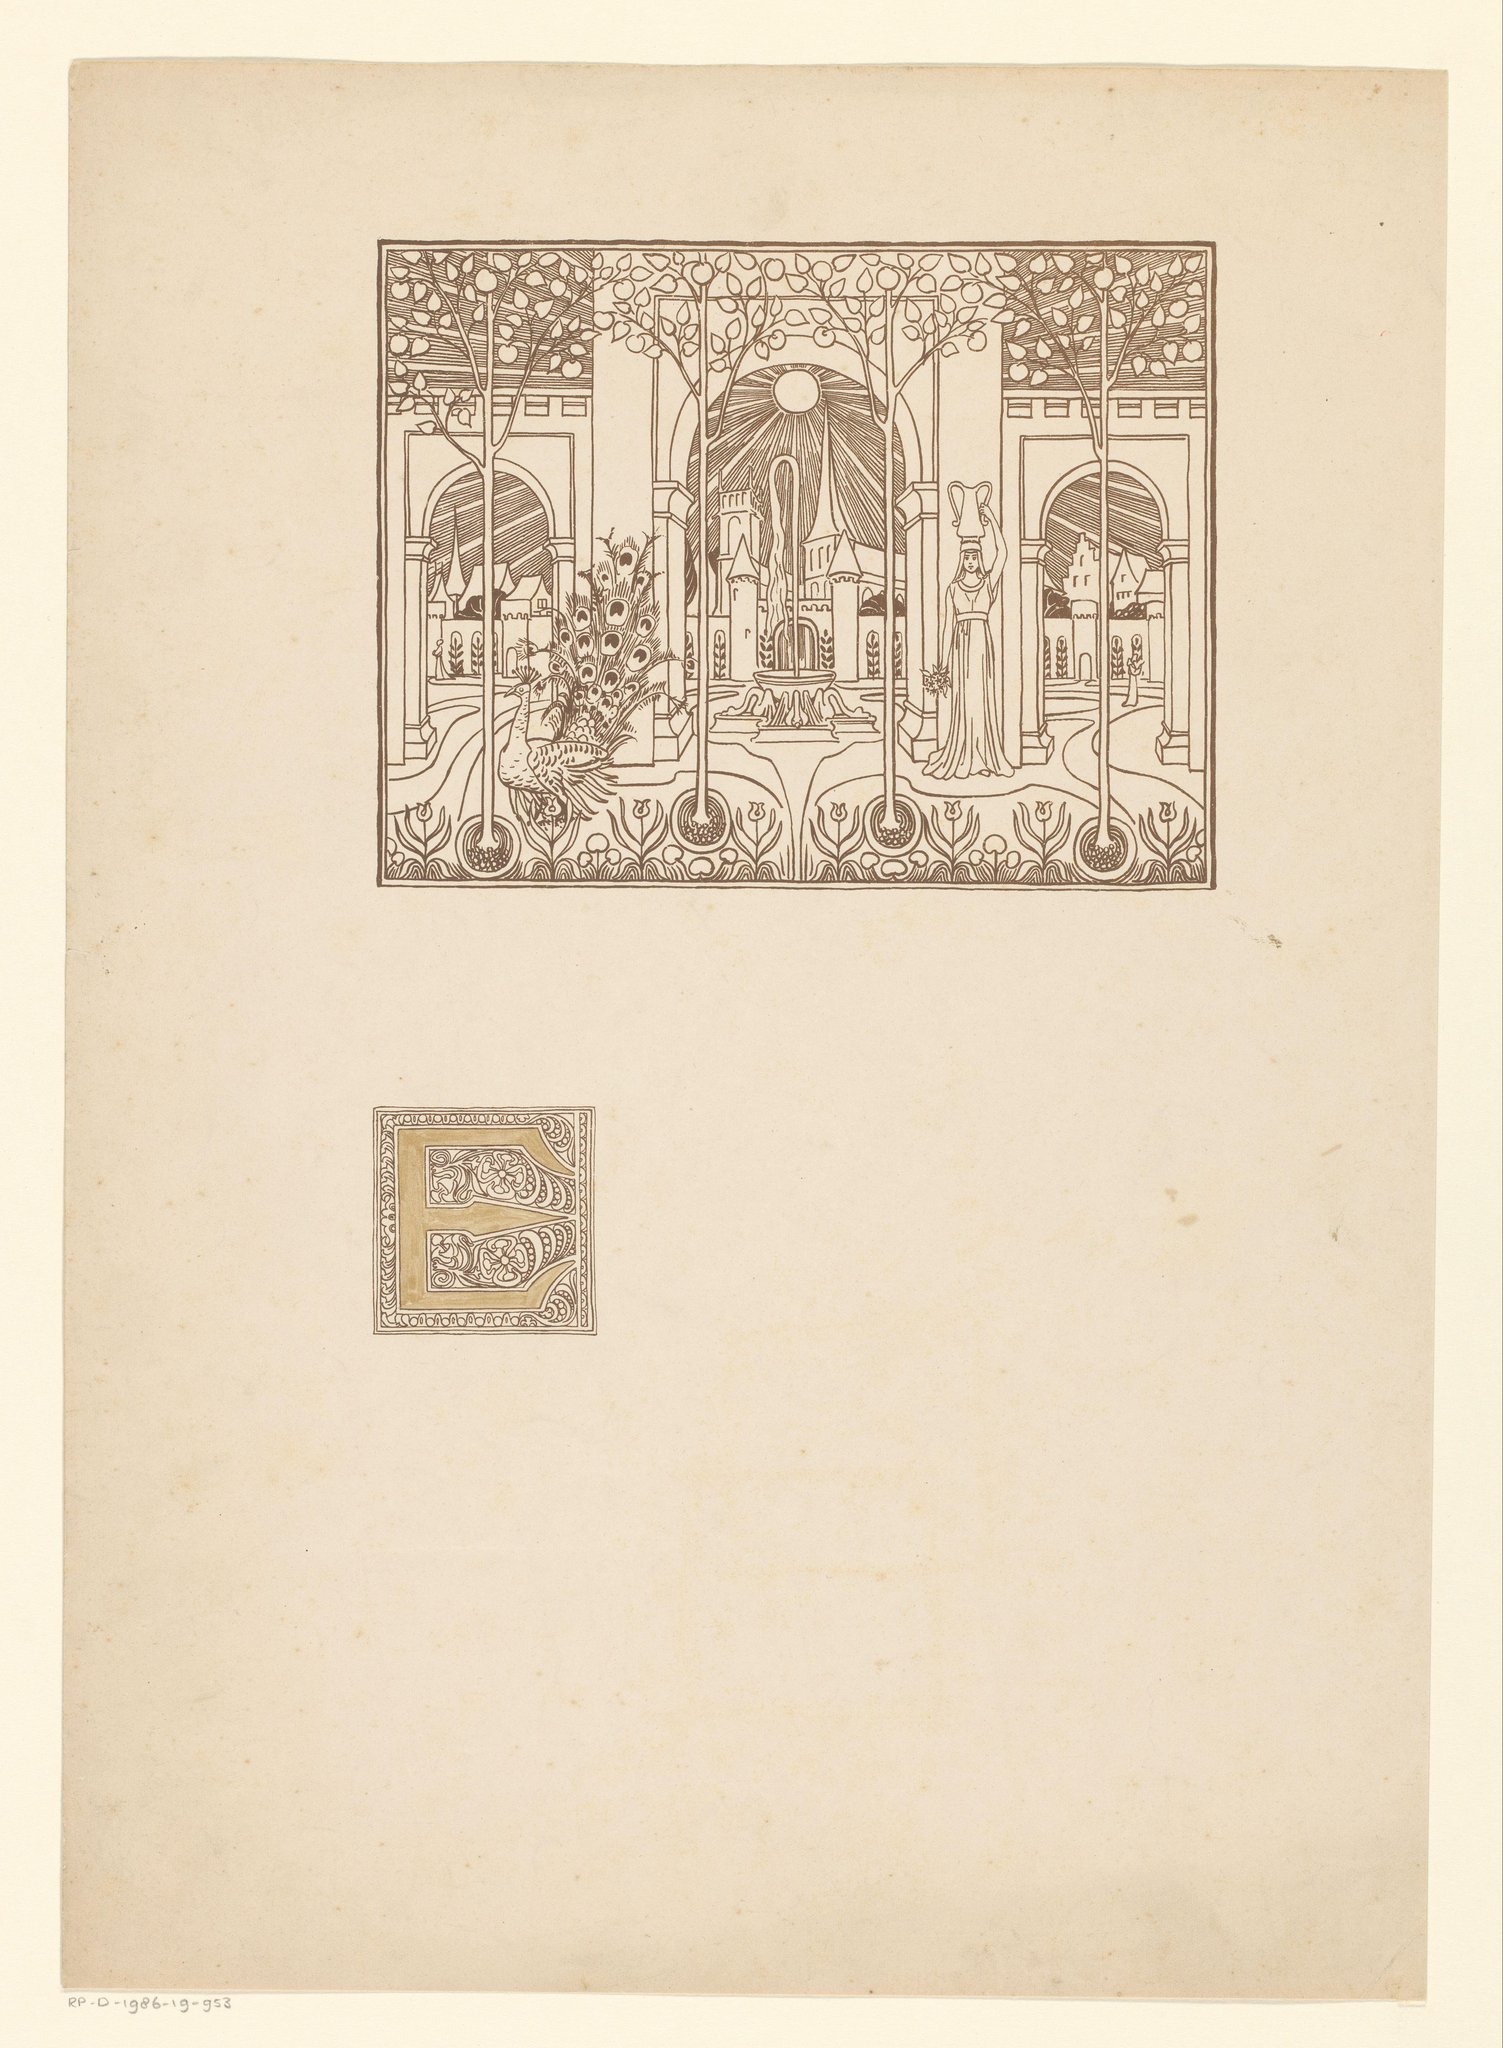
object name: print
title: Vrouw met kruik op het hoofd bij een stadspoort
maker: reinier willem petrus de vries (1874-1953)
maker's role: draughtsman, print maker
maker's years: 1874-1953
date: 1884-1952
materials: paper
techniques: hand coloring, lithograph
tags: initial, ornamental birds: peacock, city-gate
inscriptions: collector's mark: ‘R:MVS.’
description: Ontwerp voor de opmaak van een pagina in een boek met illustratie en versierde initiaal. Voor de poort lopen twee pauwen. Door de poort is een fontein en een stad met een kasteel te zien.